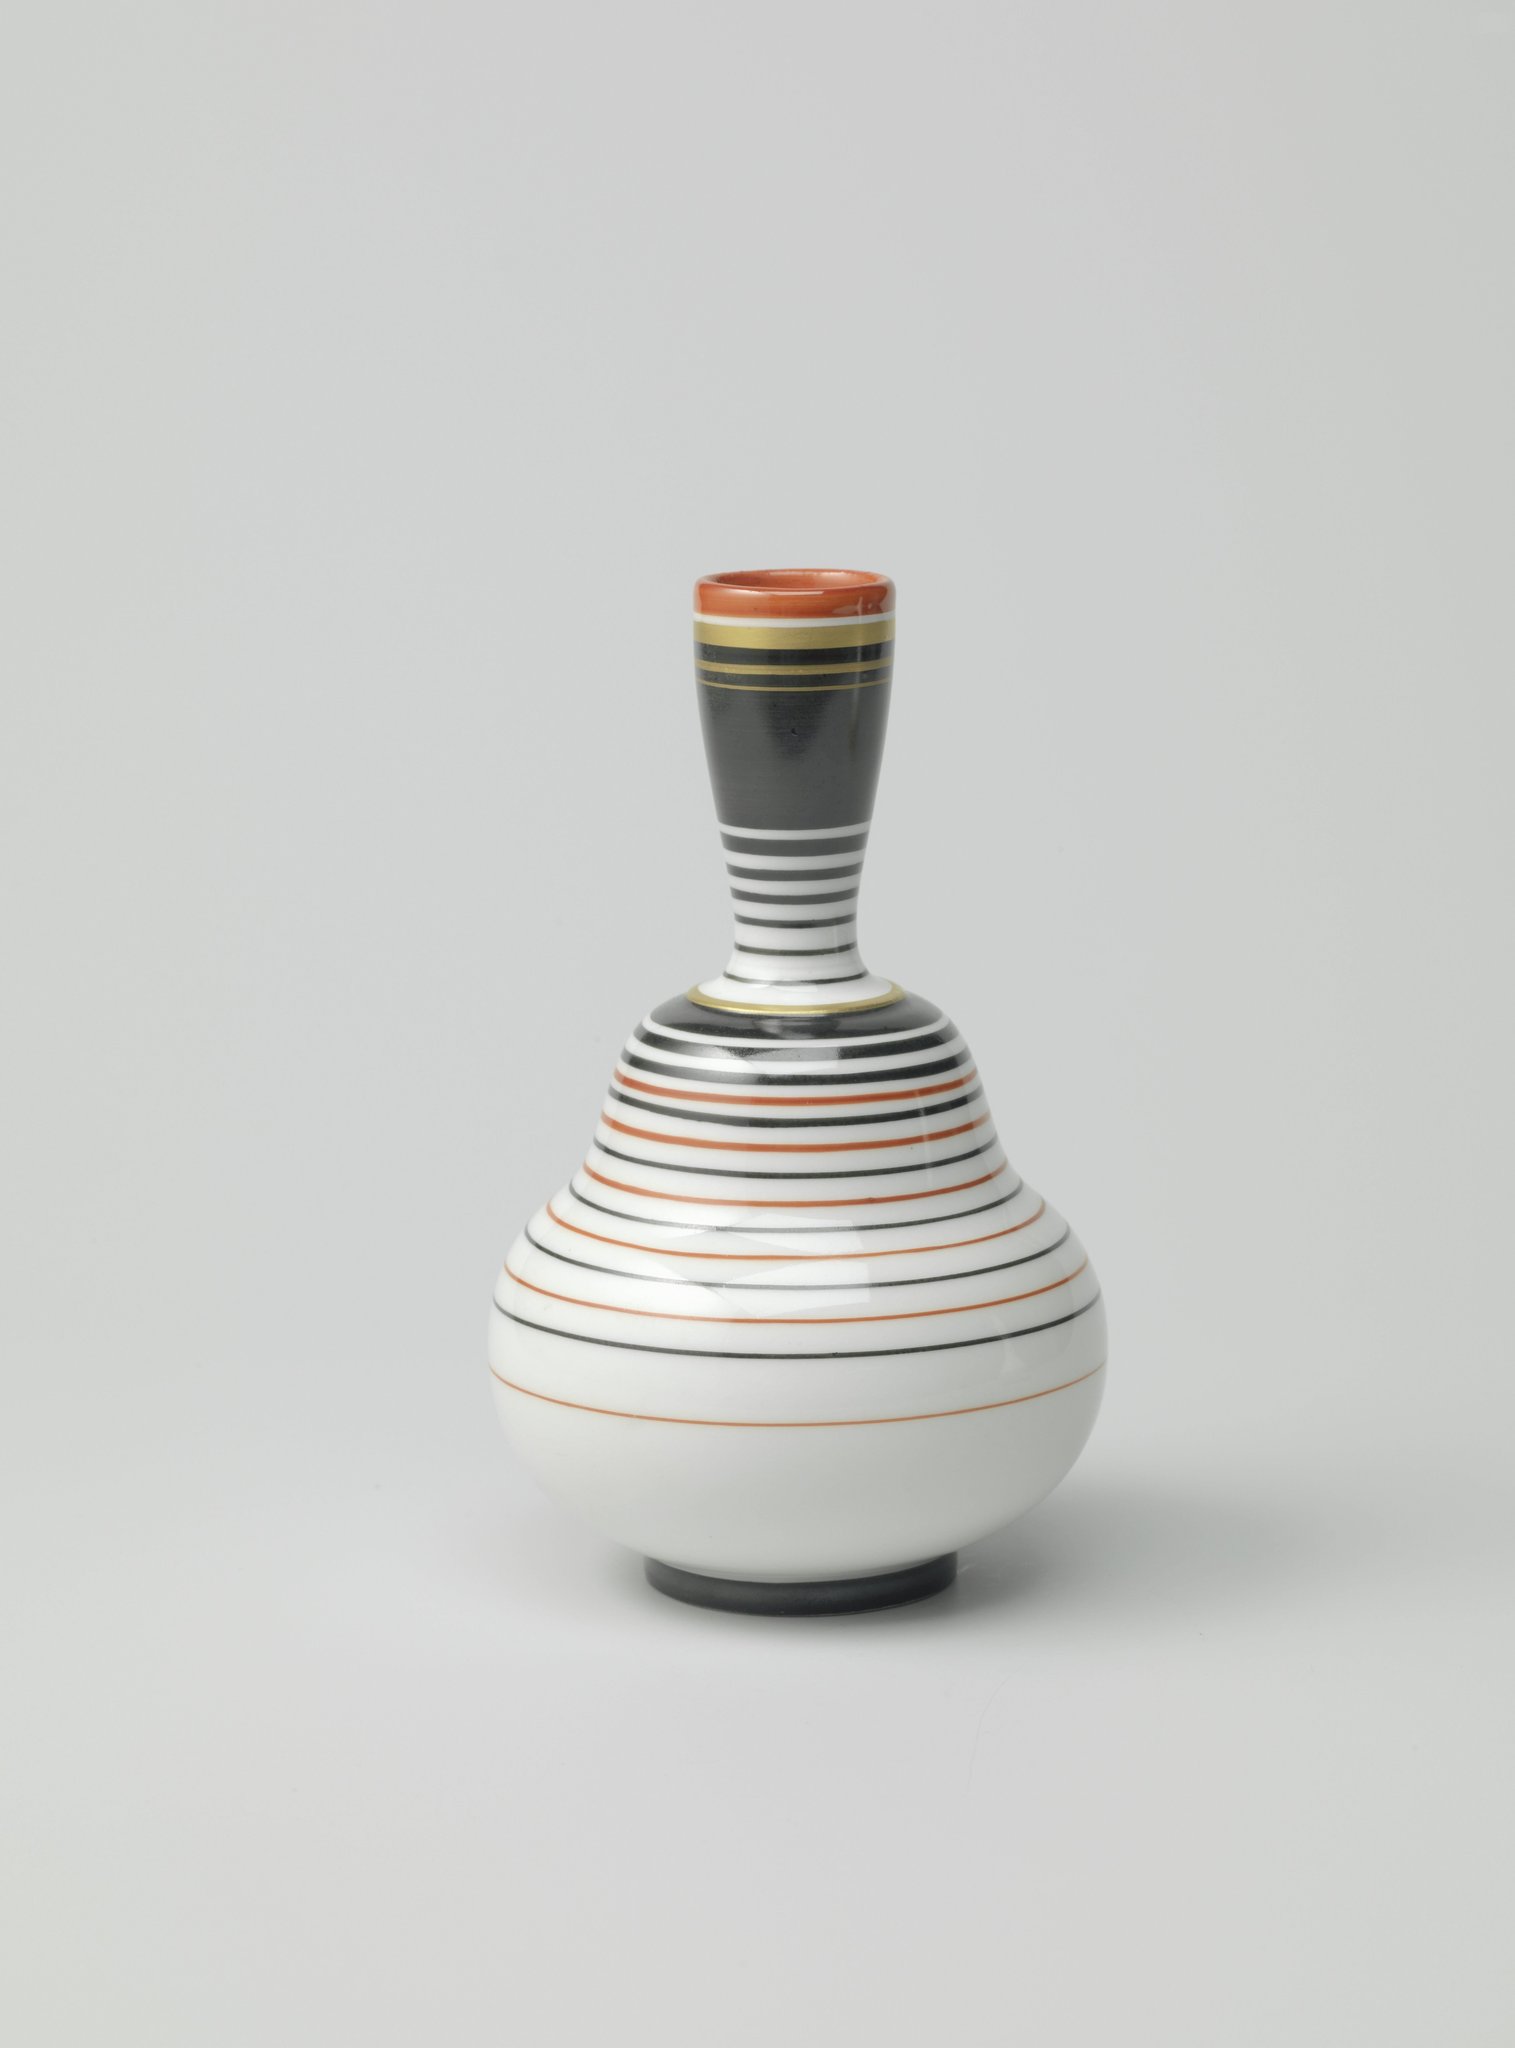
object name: vase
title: Vase with wide and narrow borders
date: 1925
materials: glaze, paint, porcelain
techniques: firing, forming, vitrification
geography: berlin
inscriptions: mark: ‘scepter/ 45[?]/84 IIII/ rode rijksappel met K.P.M./ Z.[...]’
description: Vaas van porselein, peervormig met slanke hals, versierd met rondom lopende biezen van verschillende breedte in zwart en rood. Op de schouder en vlak onder de mondrand ook enkele in goud. Gemerkt met: scepter in onderglazuurblauw en in rood met rijksappel en K.P.M., verder met 25/84 in rood, ingegrift Z en een onduidelijke jaarletter.